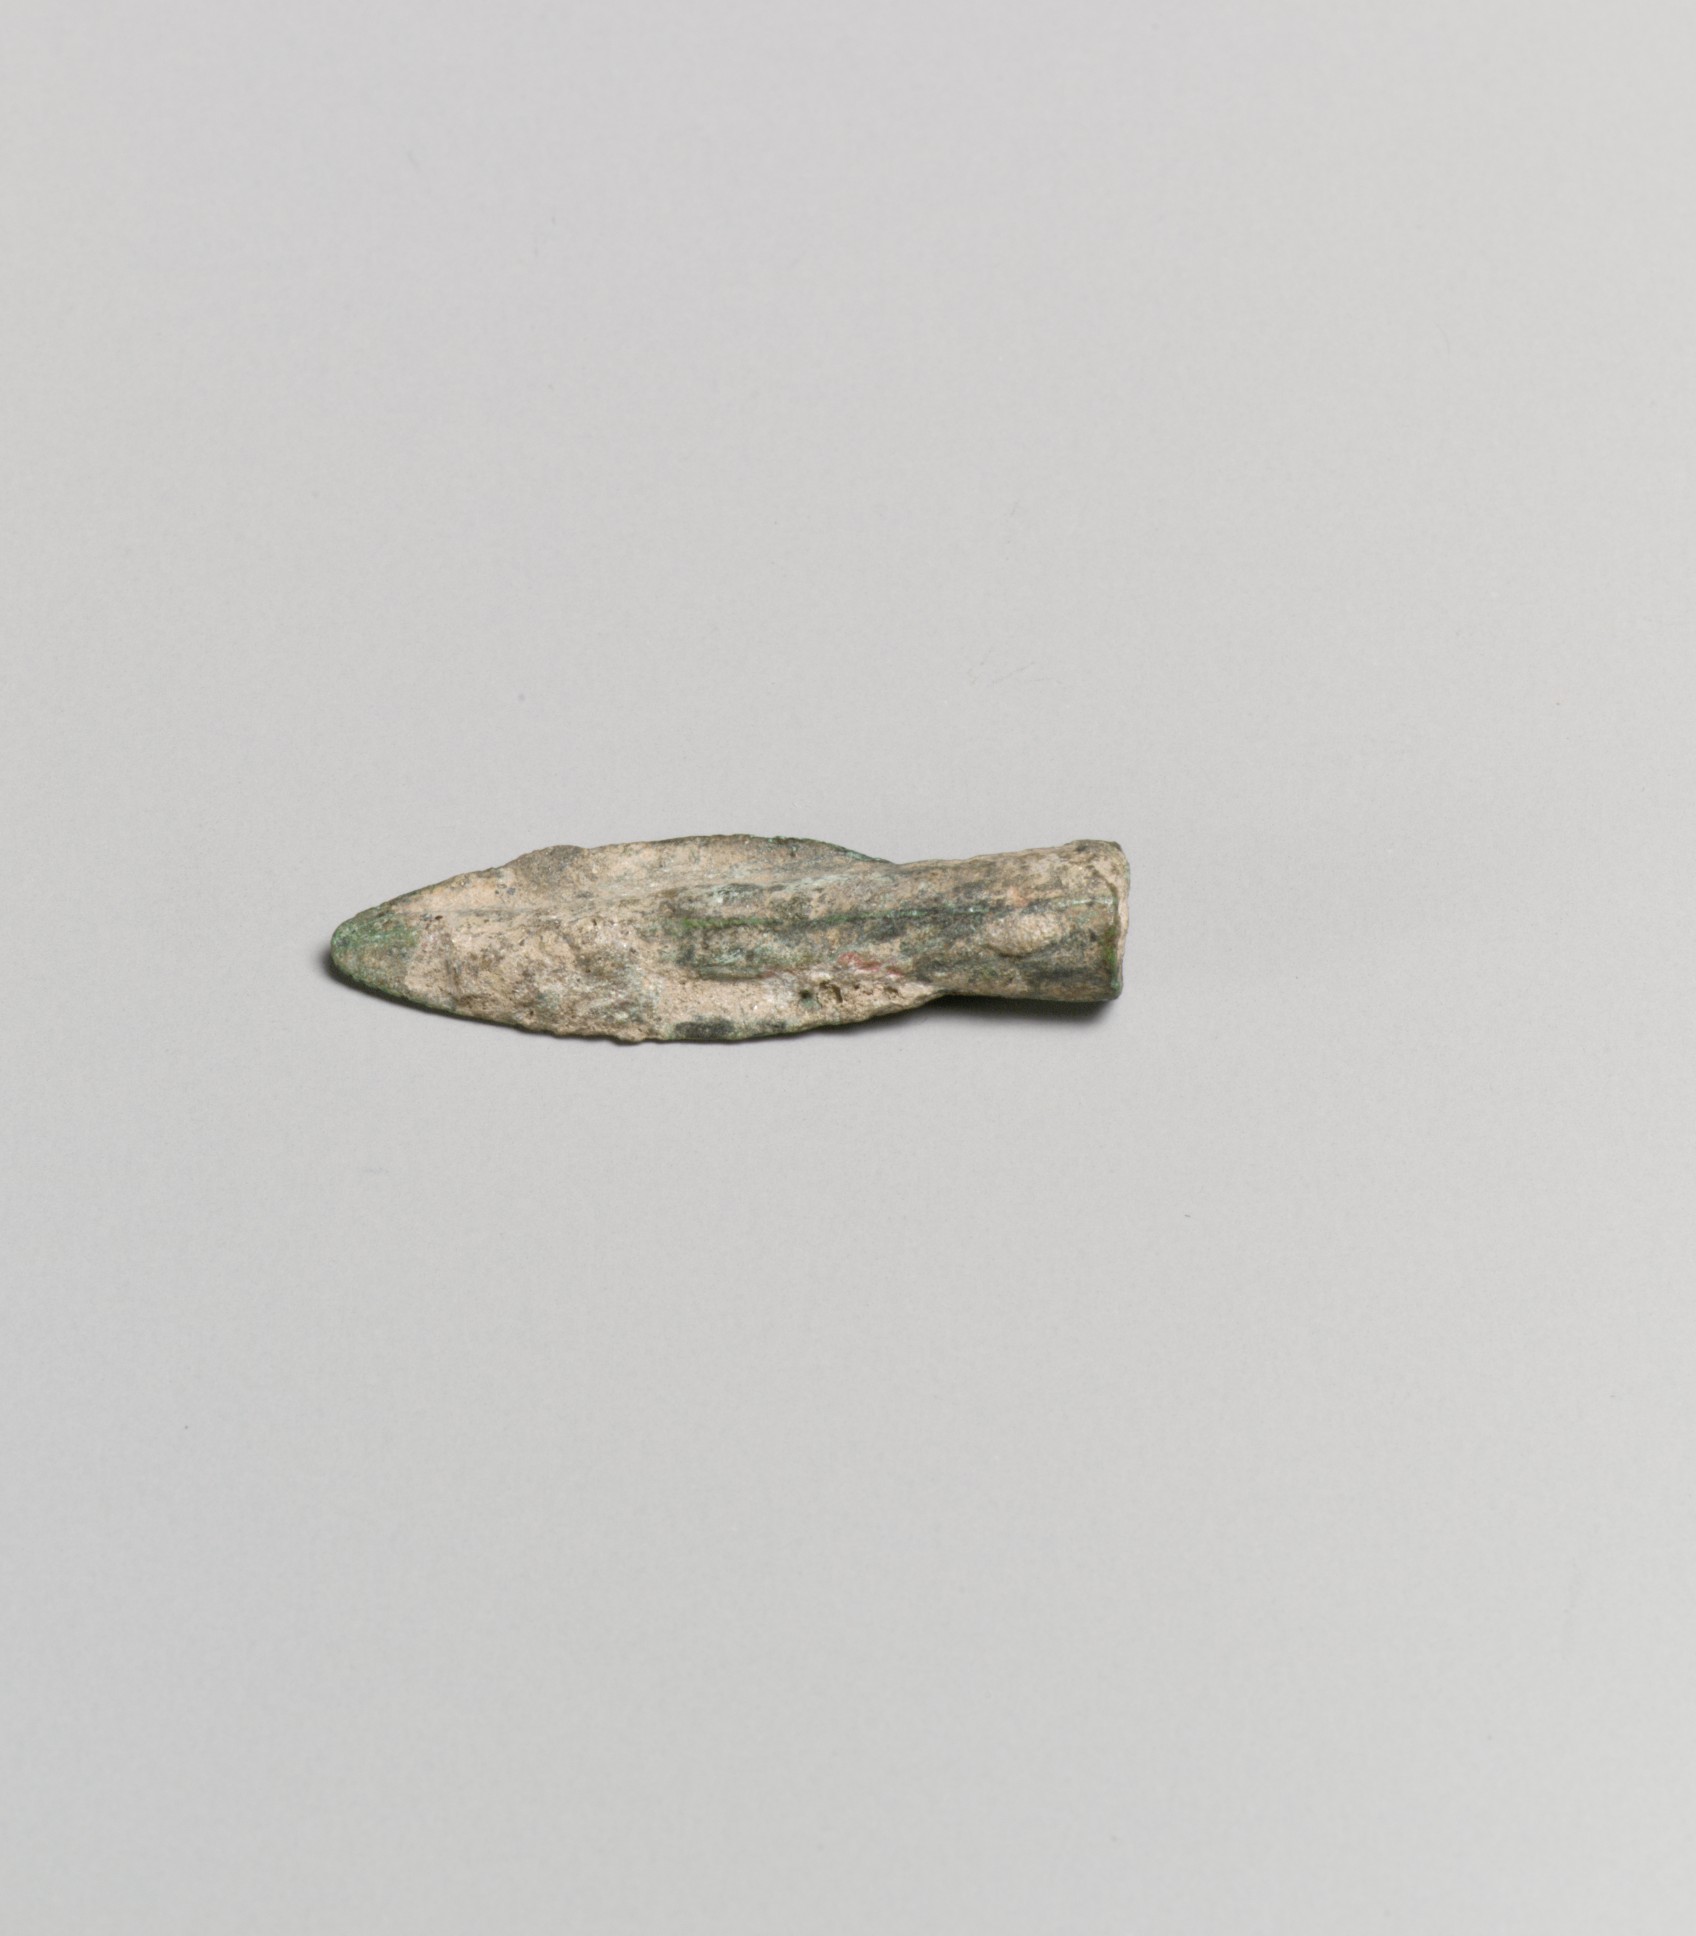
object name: arrowhead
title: Bronze arrowhead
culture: achaemenid or greek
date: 400-501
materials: bronze